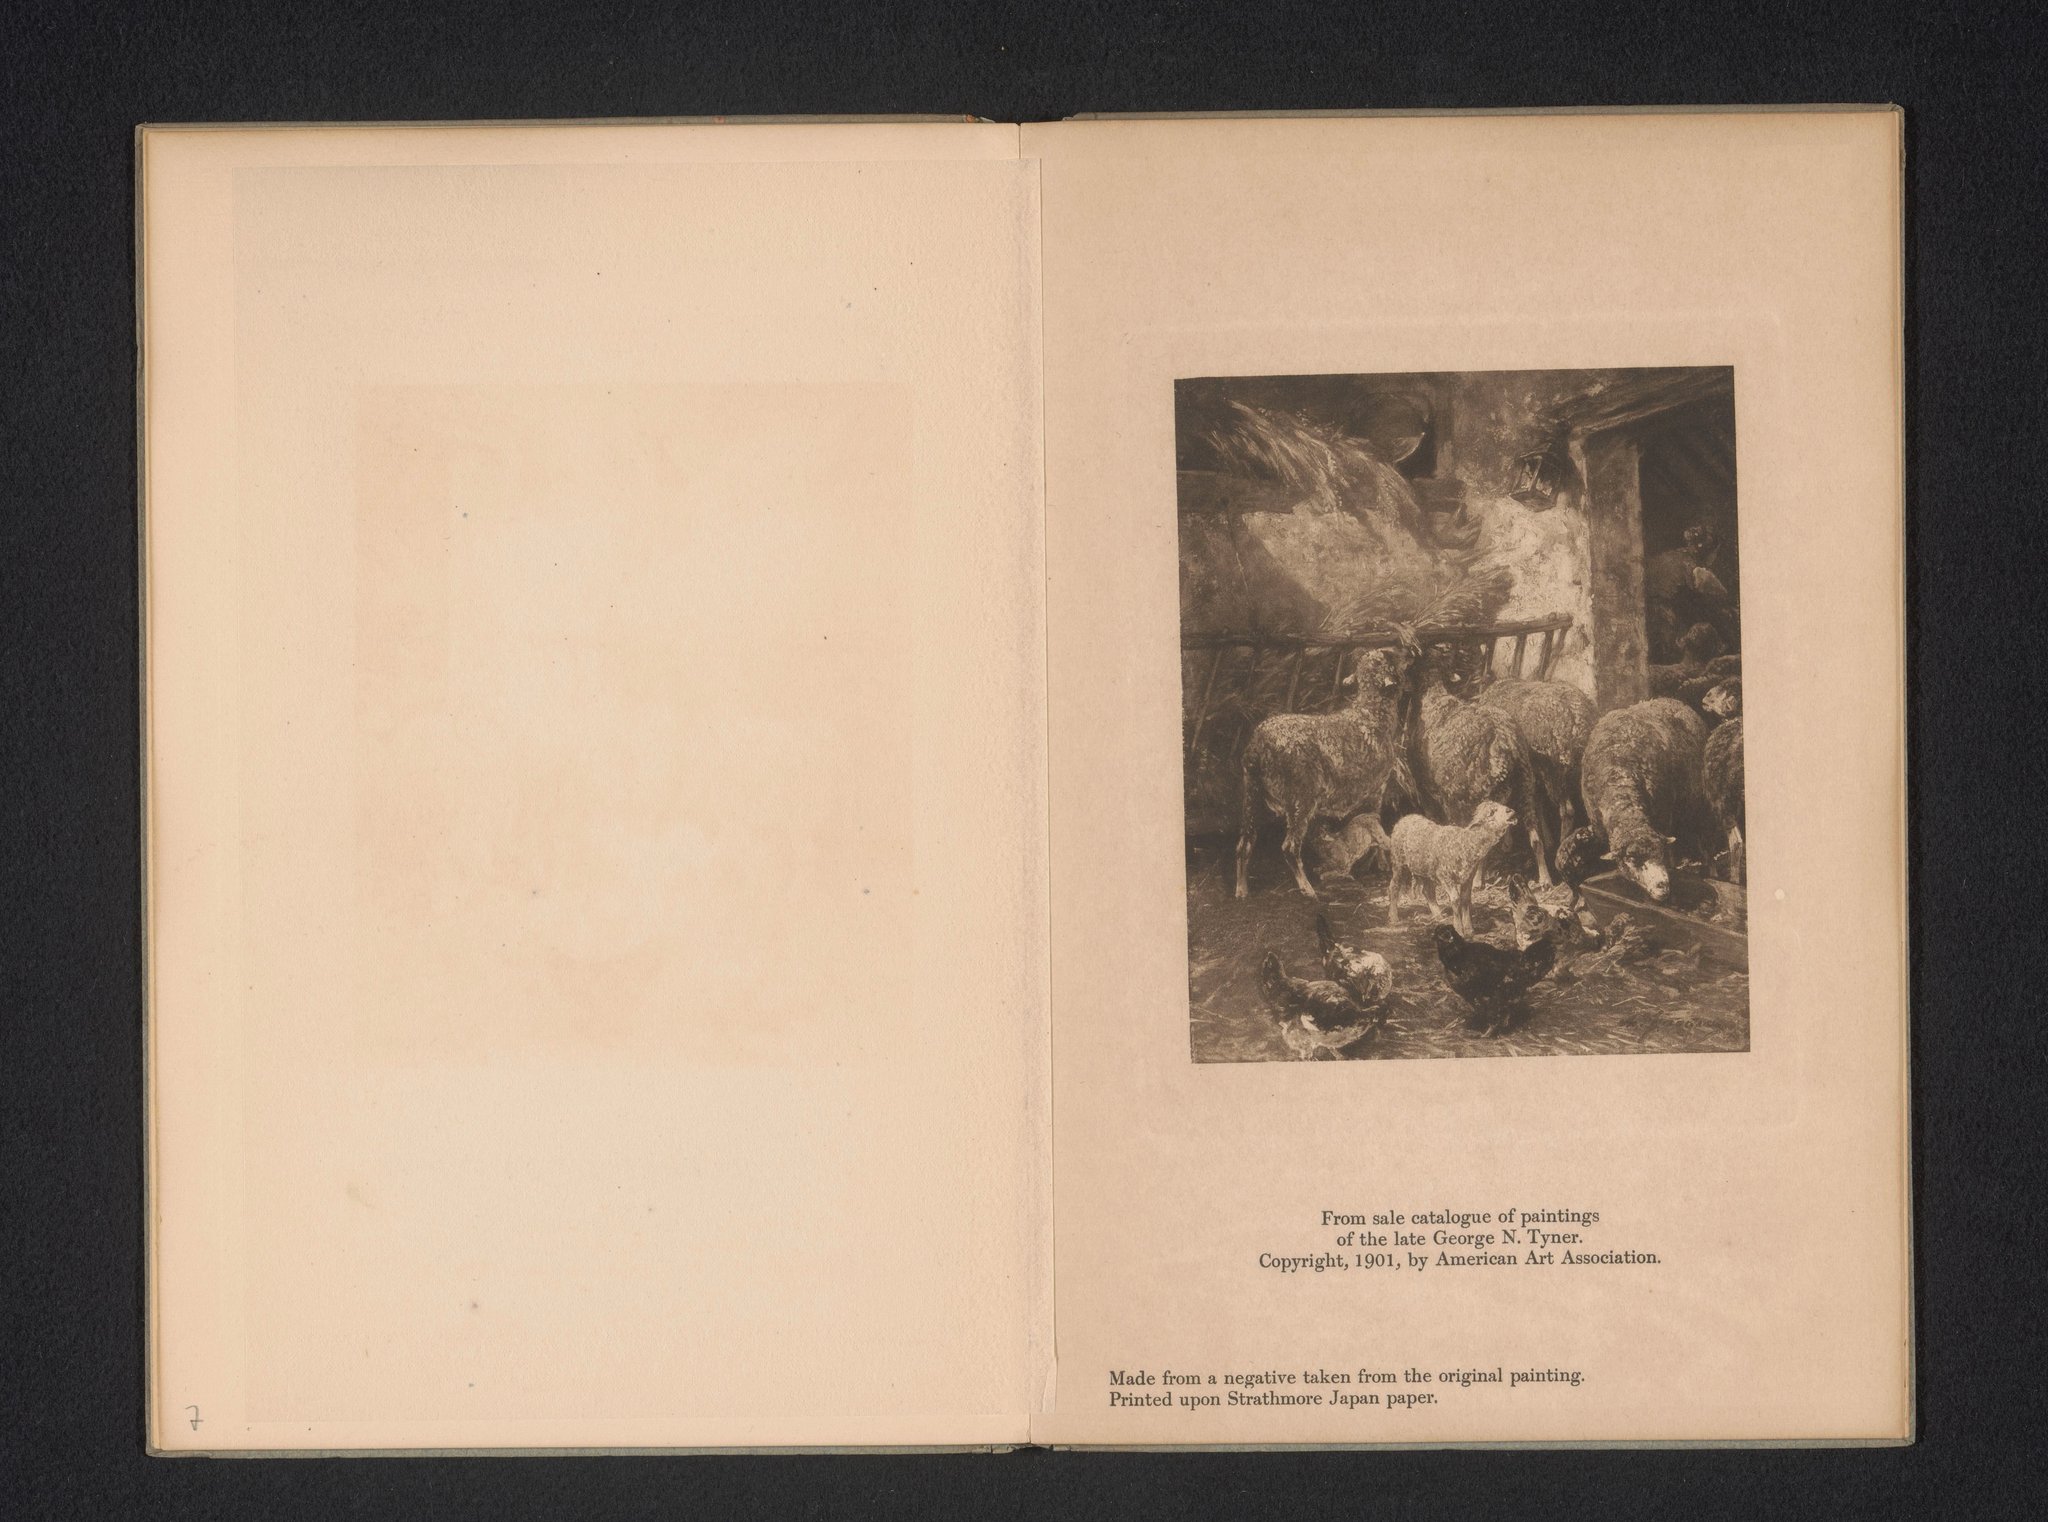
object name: photomechanical print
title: Reproductie van een schilderij van schapen en kippen in een stal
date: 1903-1908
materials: paper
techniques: photograph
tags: sheep, fowl (cock, hen, chicken, etc.), stall, stable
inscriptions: inscription: ‘From sale catalogue of paintings/ of the late George N. Tyner. Copyright, 1901 by American Art Association/ Made from a negative taken from the original painting. Printed upon Strathmore Japan paper.’